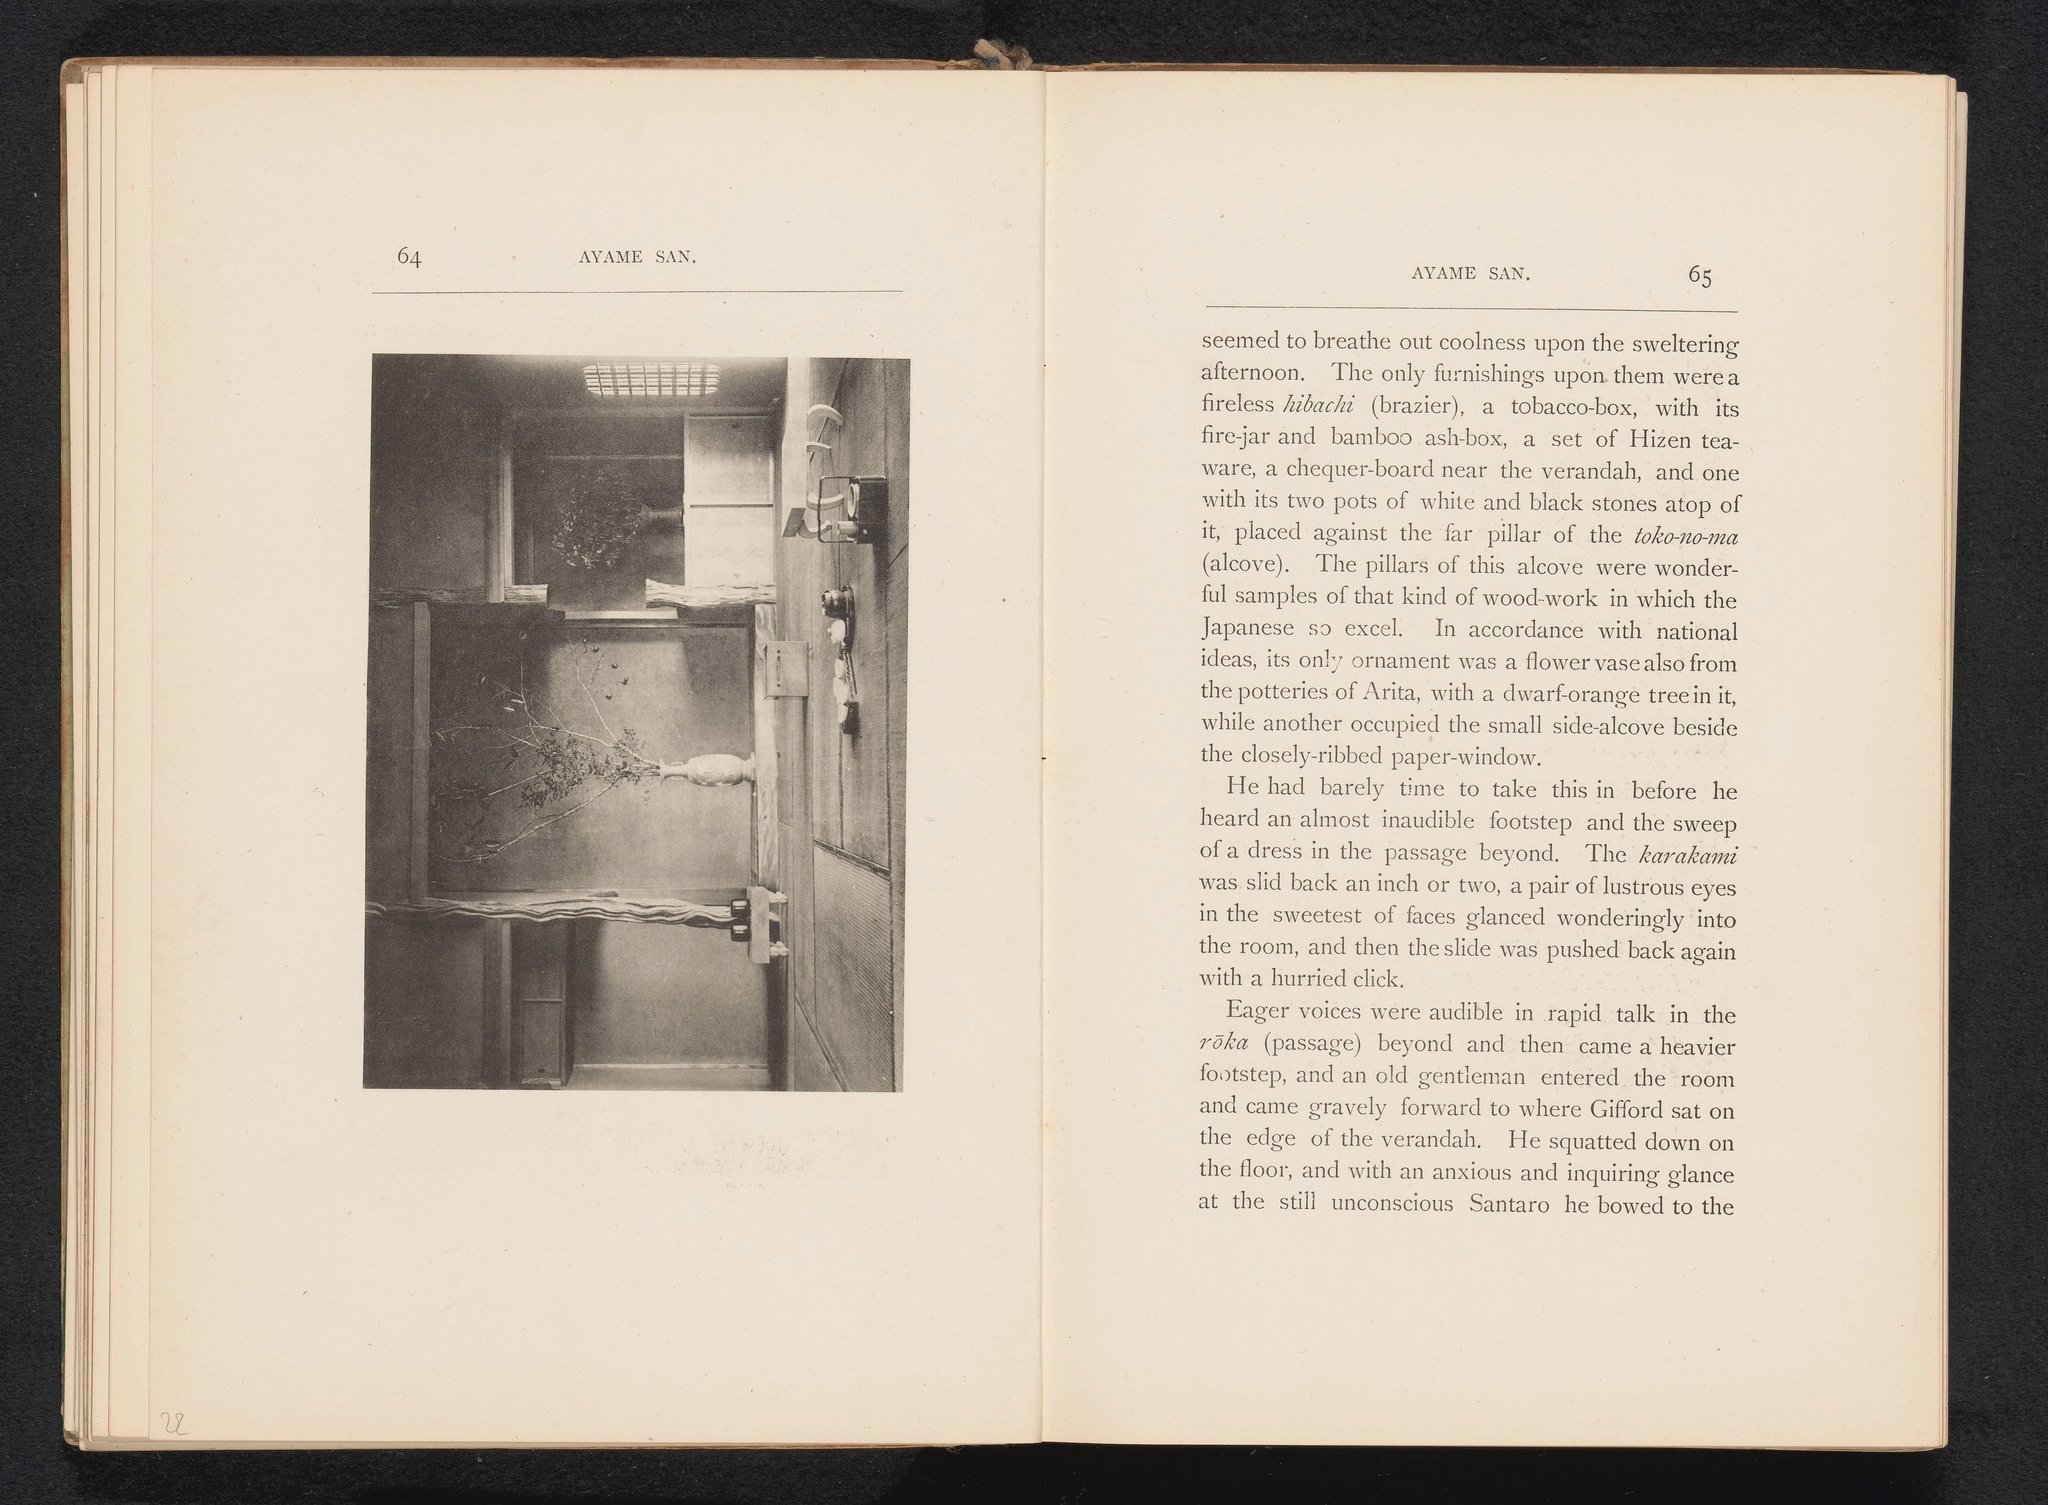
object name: photomechanical print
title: Interieur van een woonkamer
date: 1882-1892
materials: paper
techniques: photograph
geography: japan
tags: interior ~ representation of a building, living-room, parlour, sitting-room